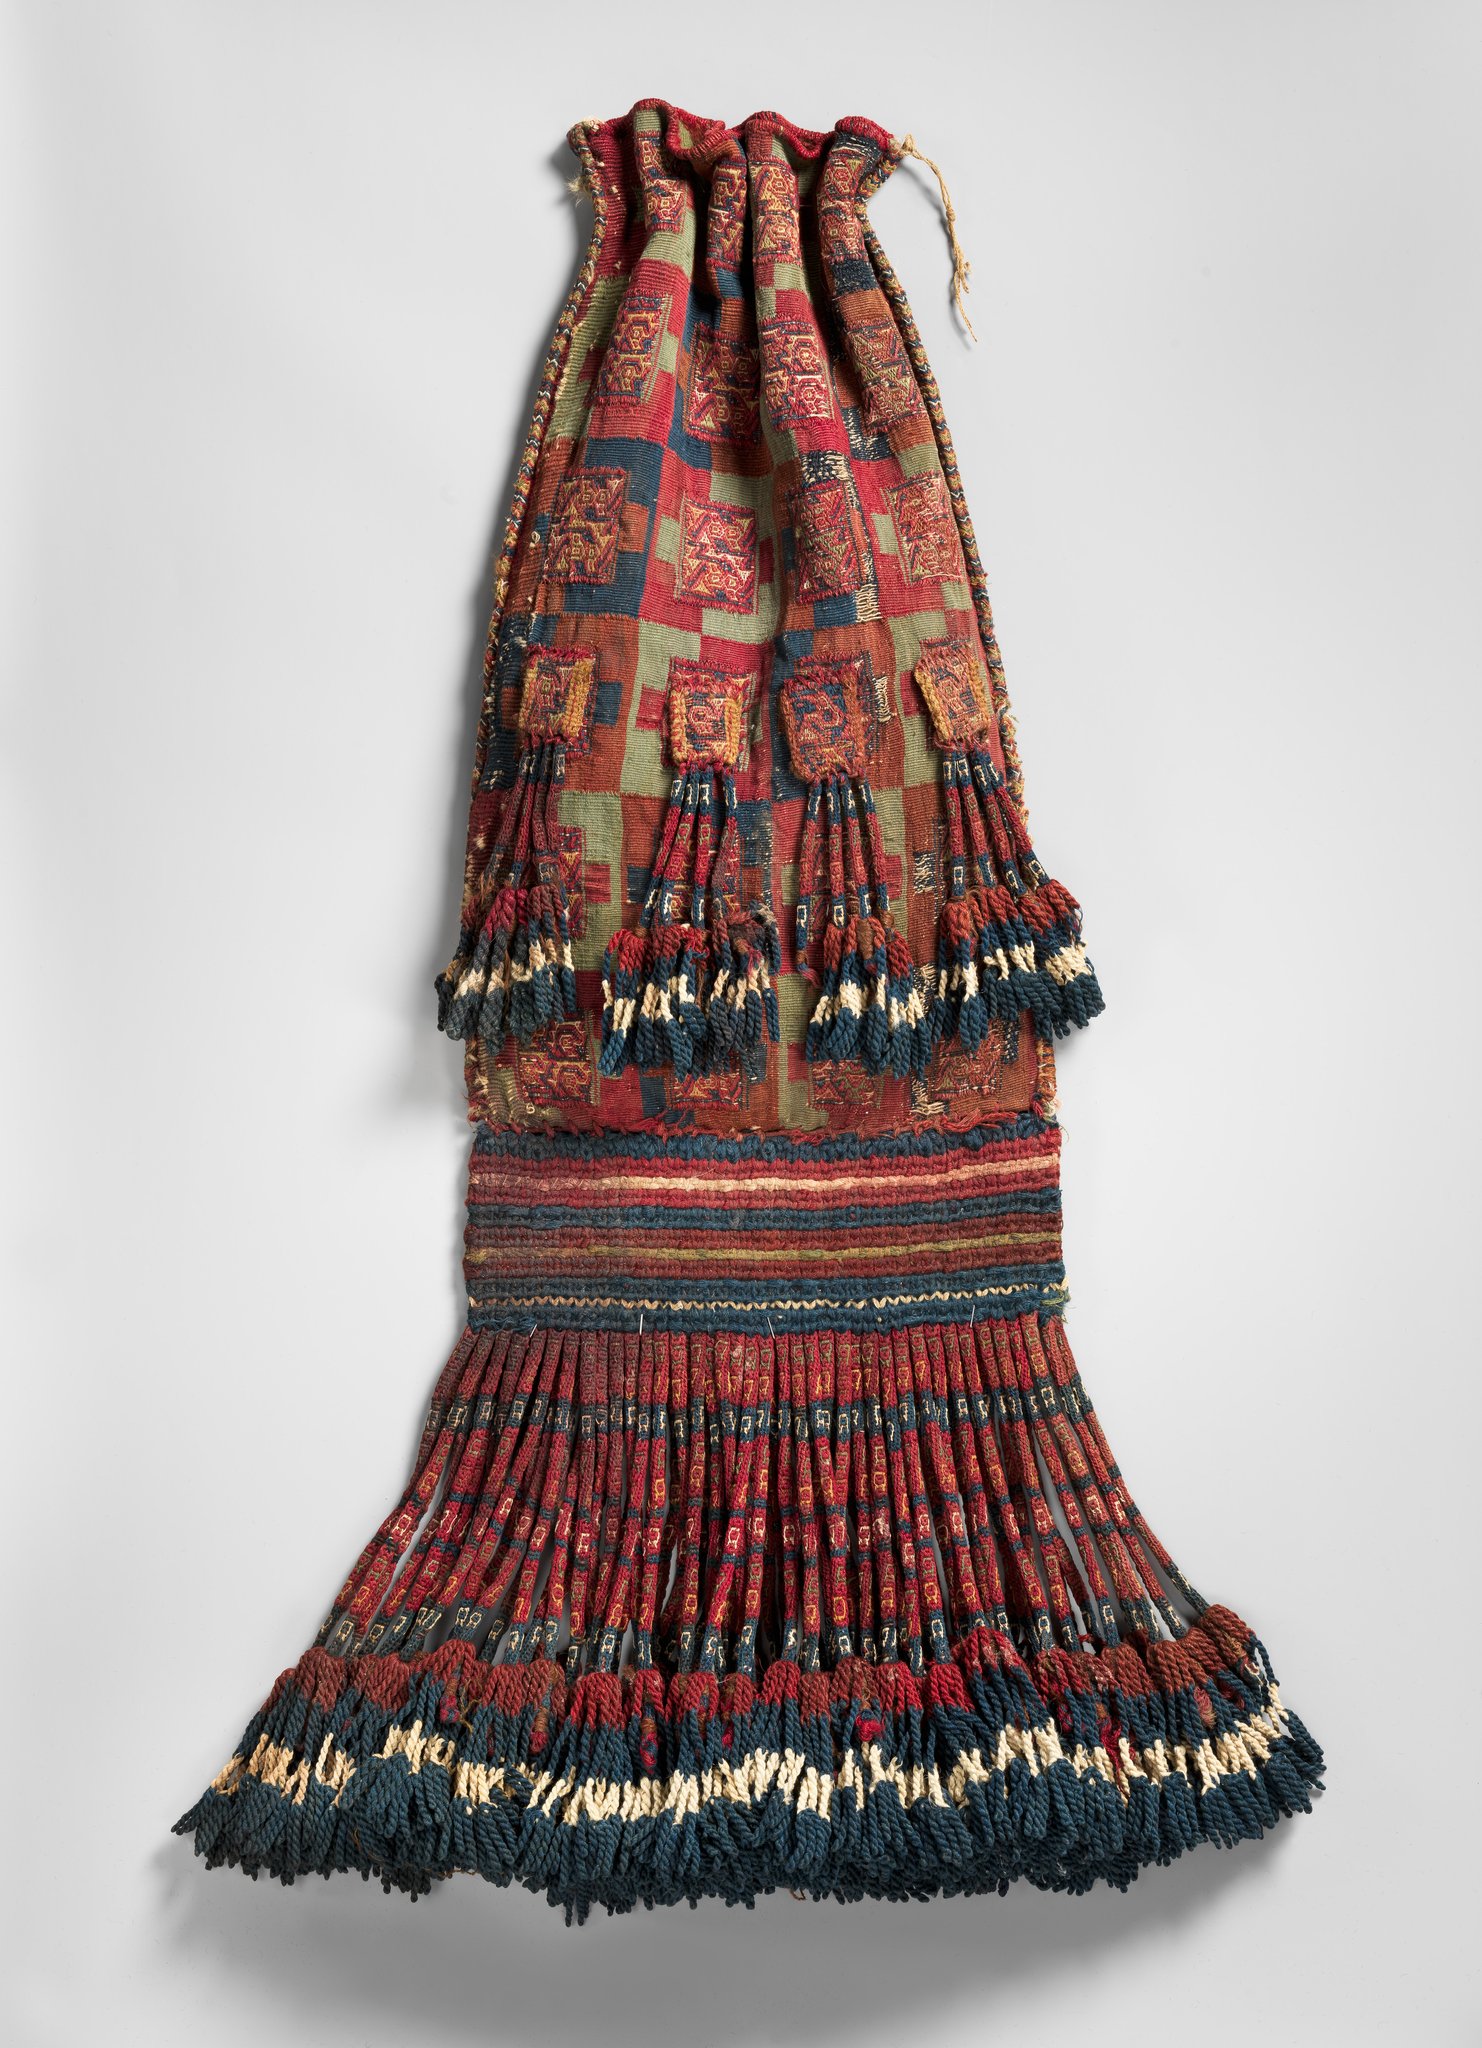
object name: bag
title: Bag with fringe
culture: chuquibamba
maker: chuquibamba artist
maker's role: artist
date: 1101-1600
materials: animal fiber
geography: peru